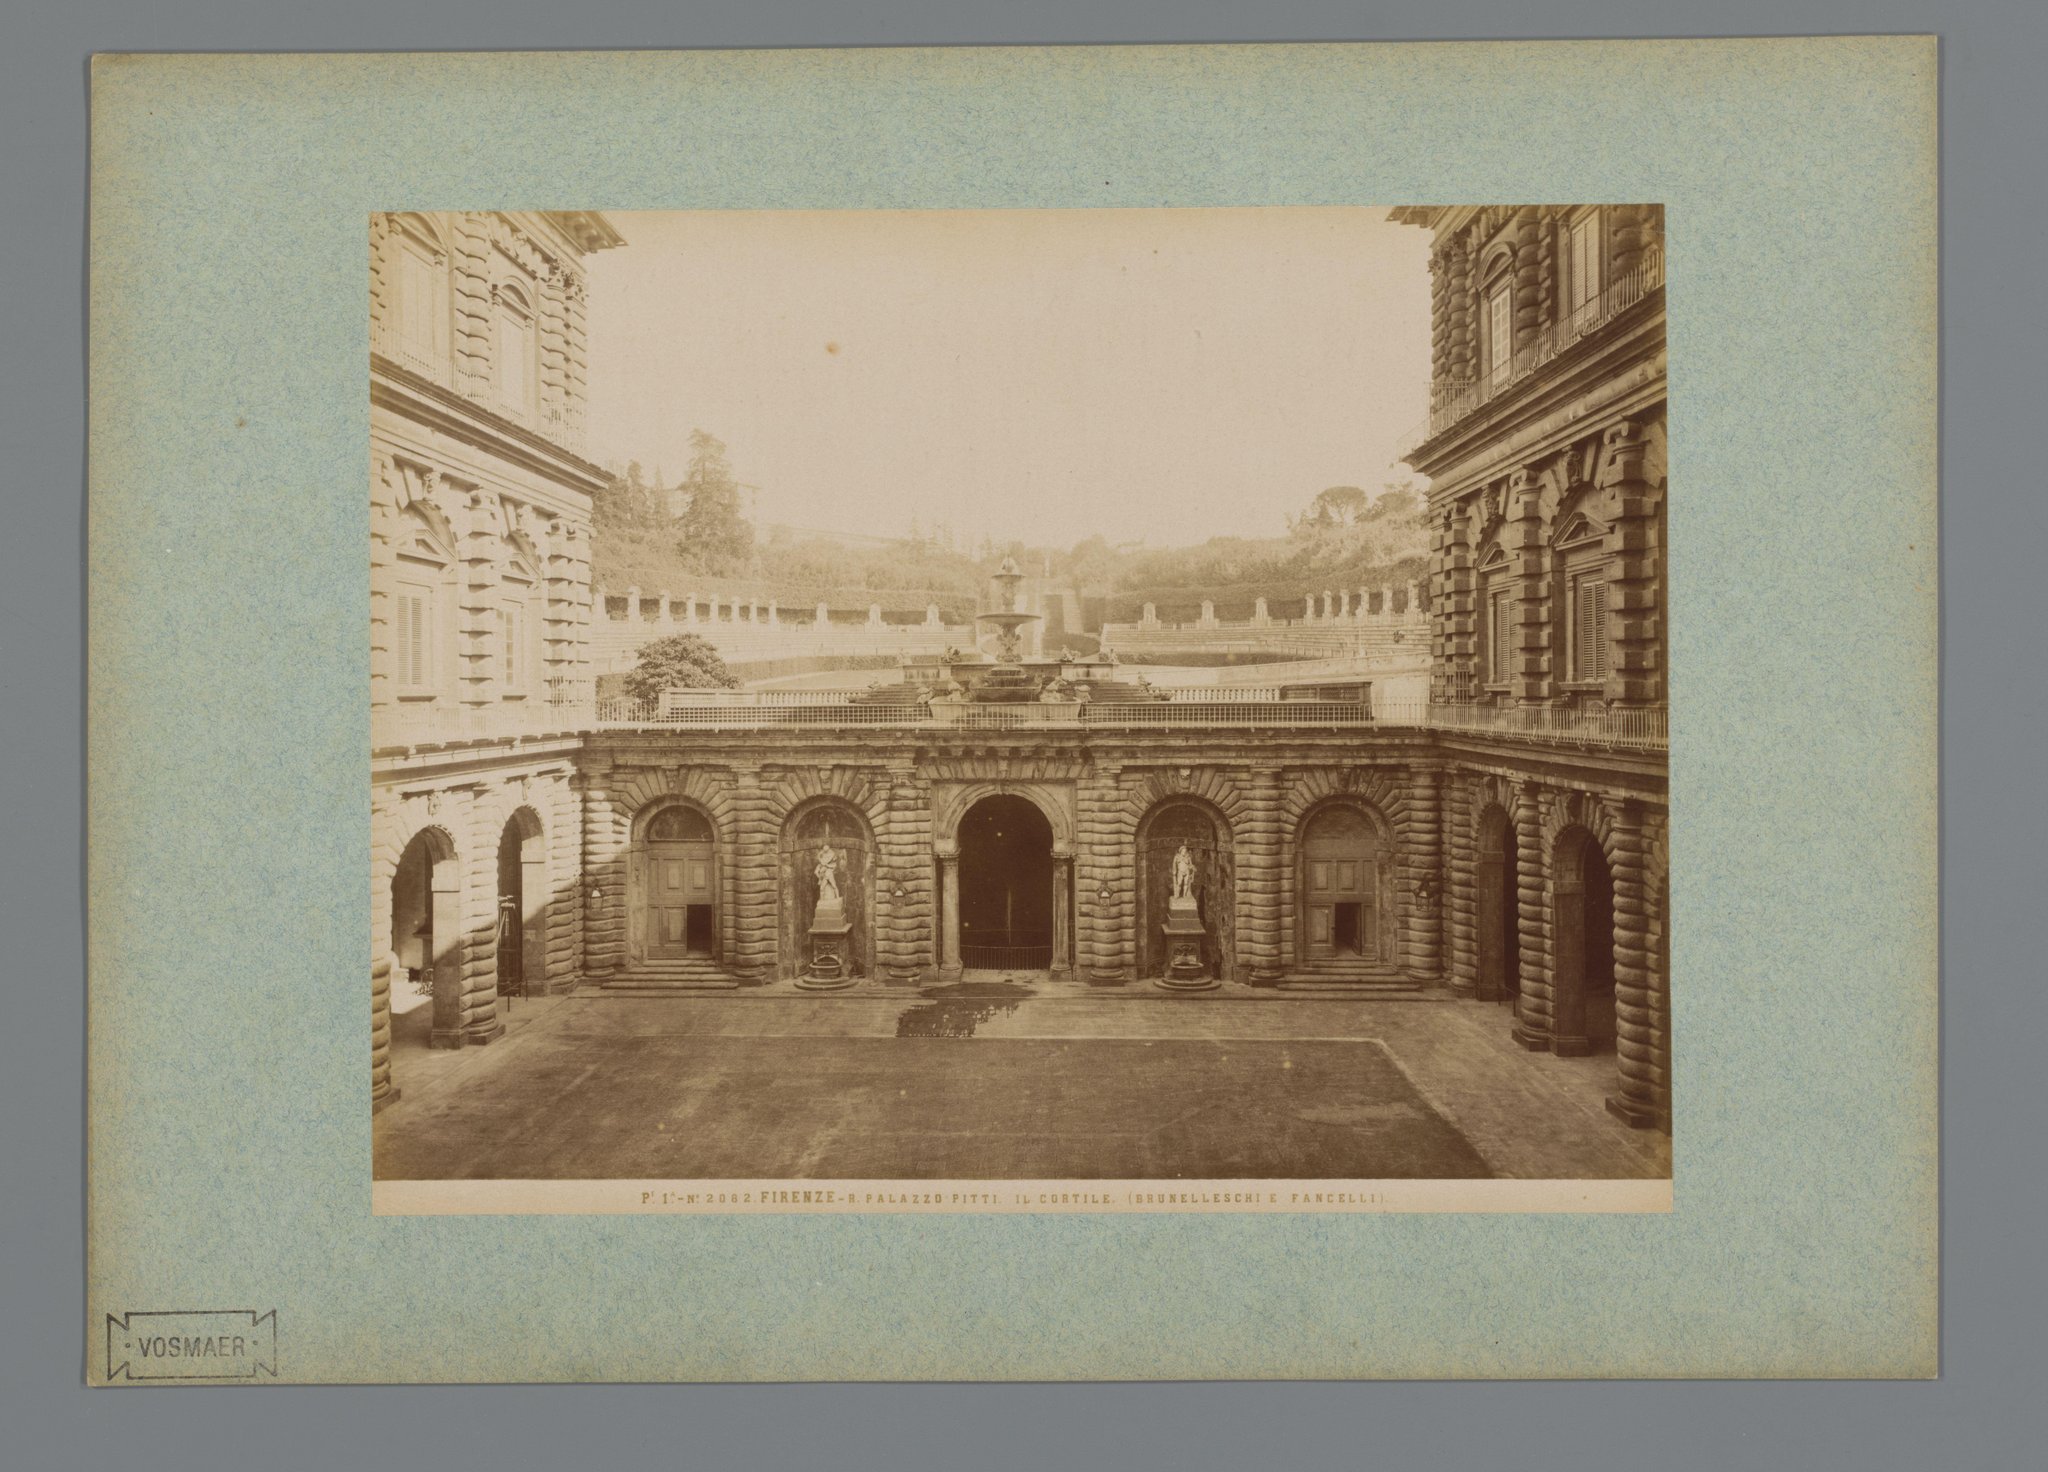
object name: photograph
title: Firenze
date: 1851-1890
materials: cardboard, paper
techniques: albumen print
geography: florence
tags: inner court of palace or 'hôtel'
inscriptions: collector's mark: ‘VOSMAER’, number: ‘Pe. 1A. - No. 2082.’